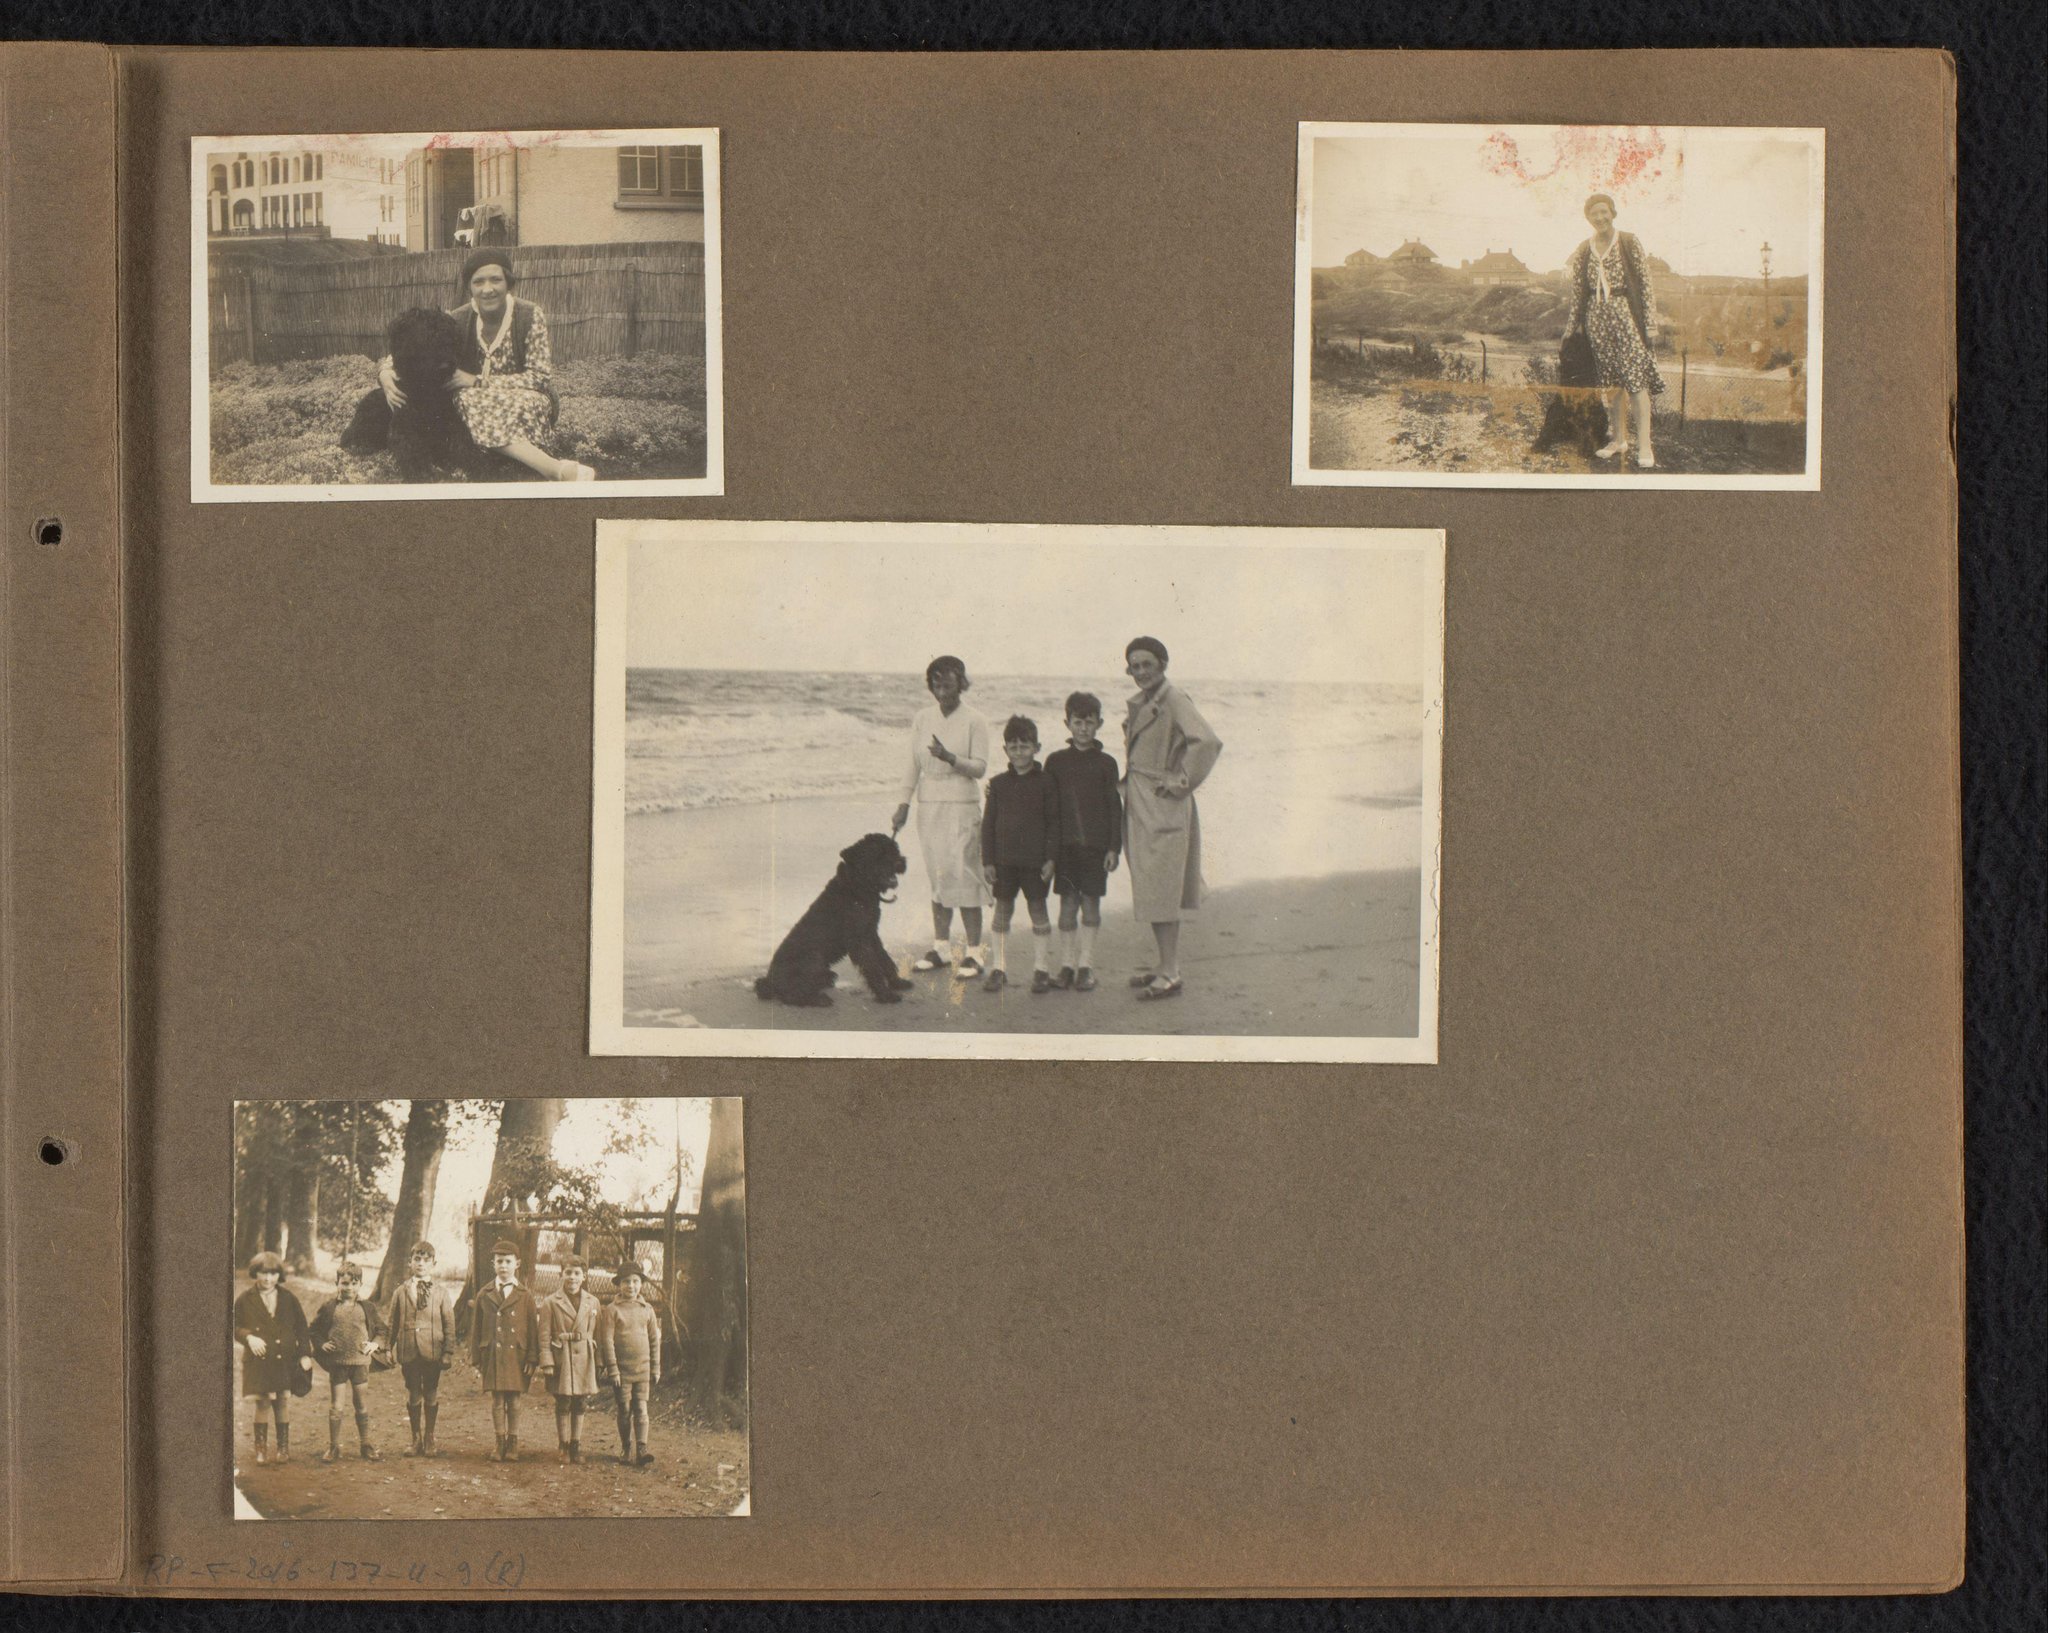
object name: photograph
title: Loentje Furnée met kinderen op een strand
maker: carolina frederika onnen (lien/loen)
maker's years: 1896-1983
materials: paper, cardboard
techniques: gelatin silver print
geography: netherlands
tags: beach (as place of recreation), netherlands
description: Deze foto's zijn onderdeel van een album.